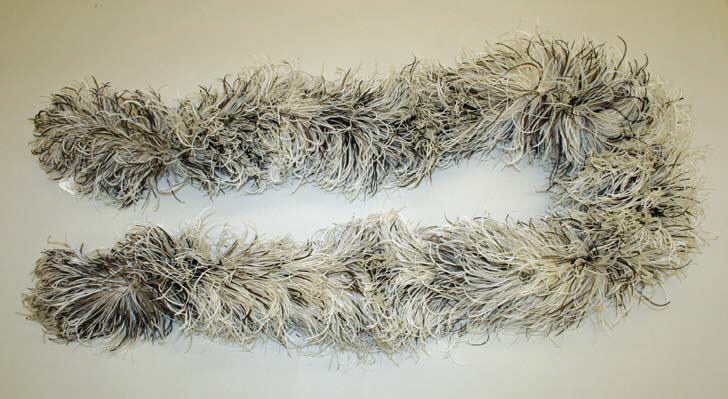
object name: boa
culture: american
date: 1890-1900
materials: feather